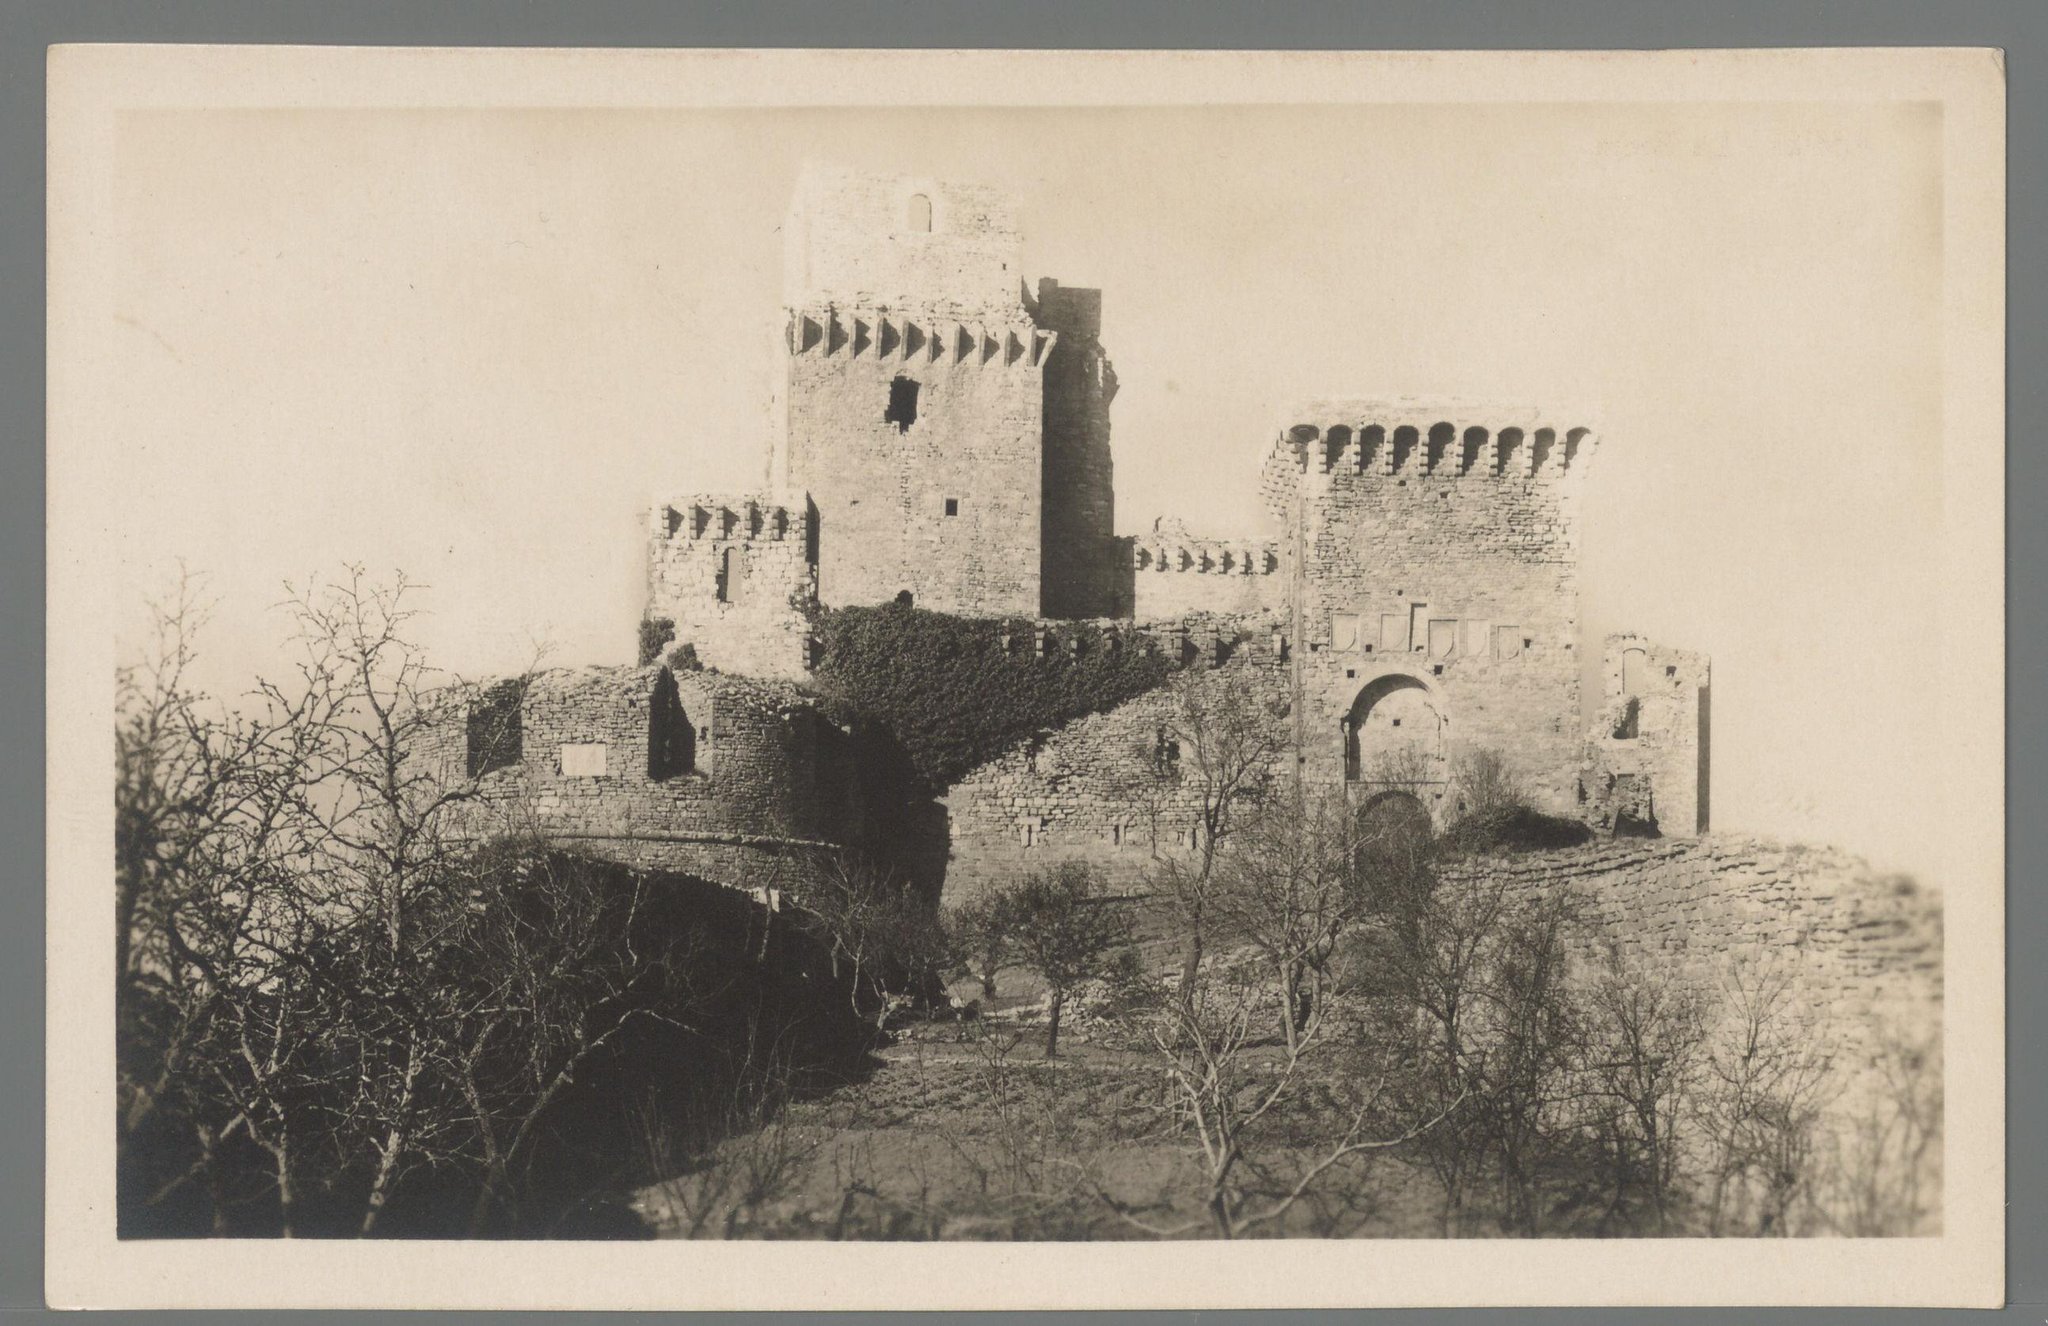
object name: photograph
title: Assisi. La Rocca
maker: Anonymous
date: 1925-1940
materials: photographic support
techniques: photography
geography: rome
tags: fortress